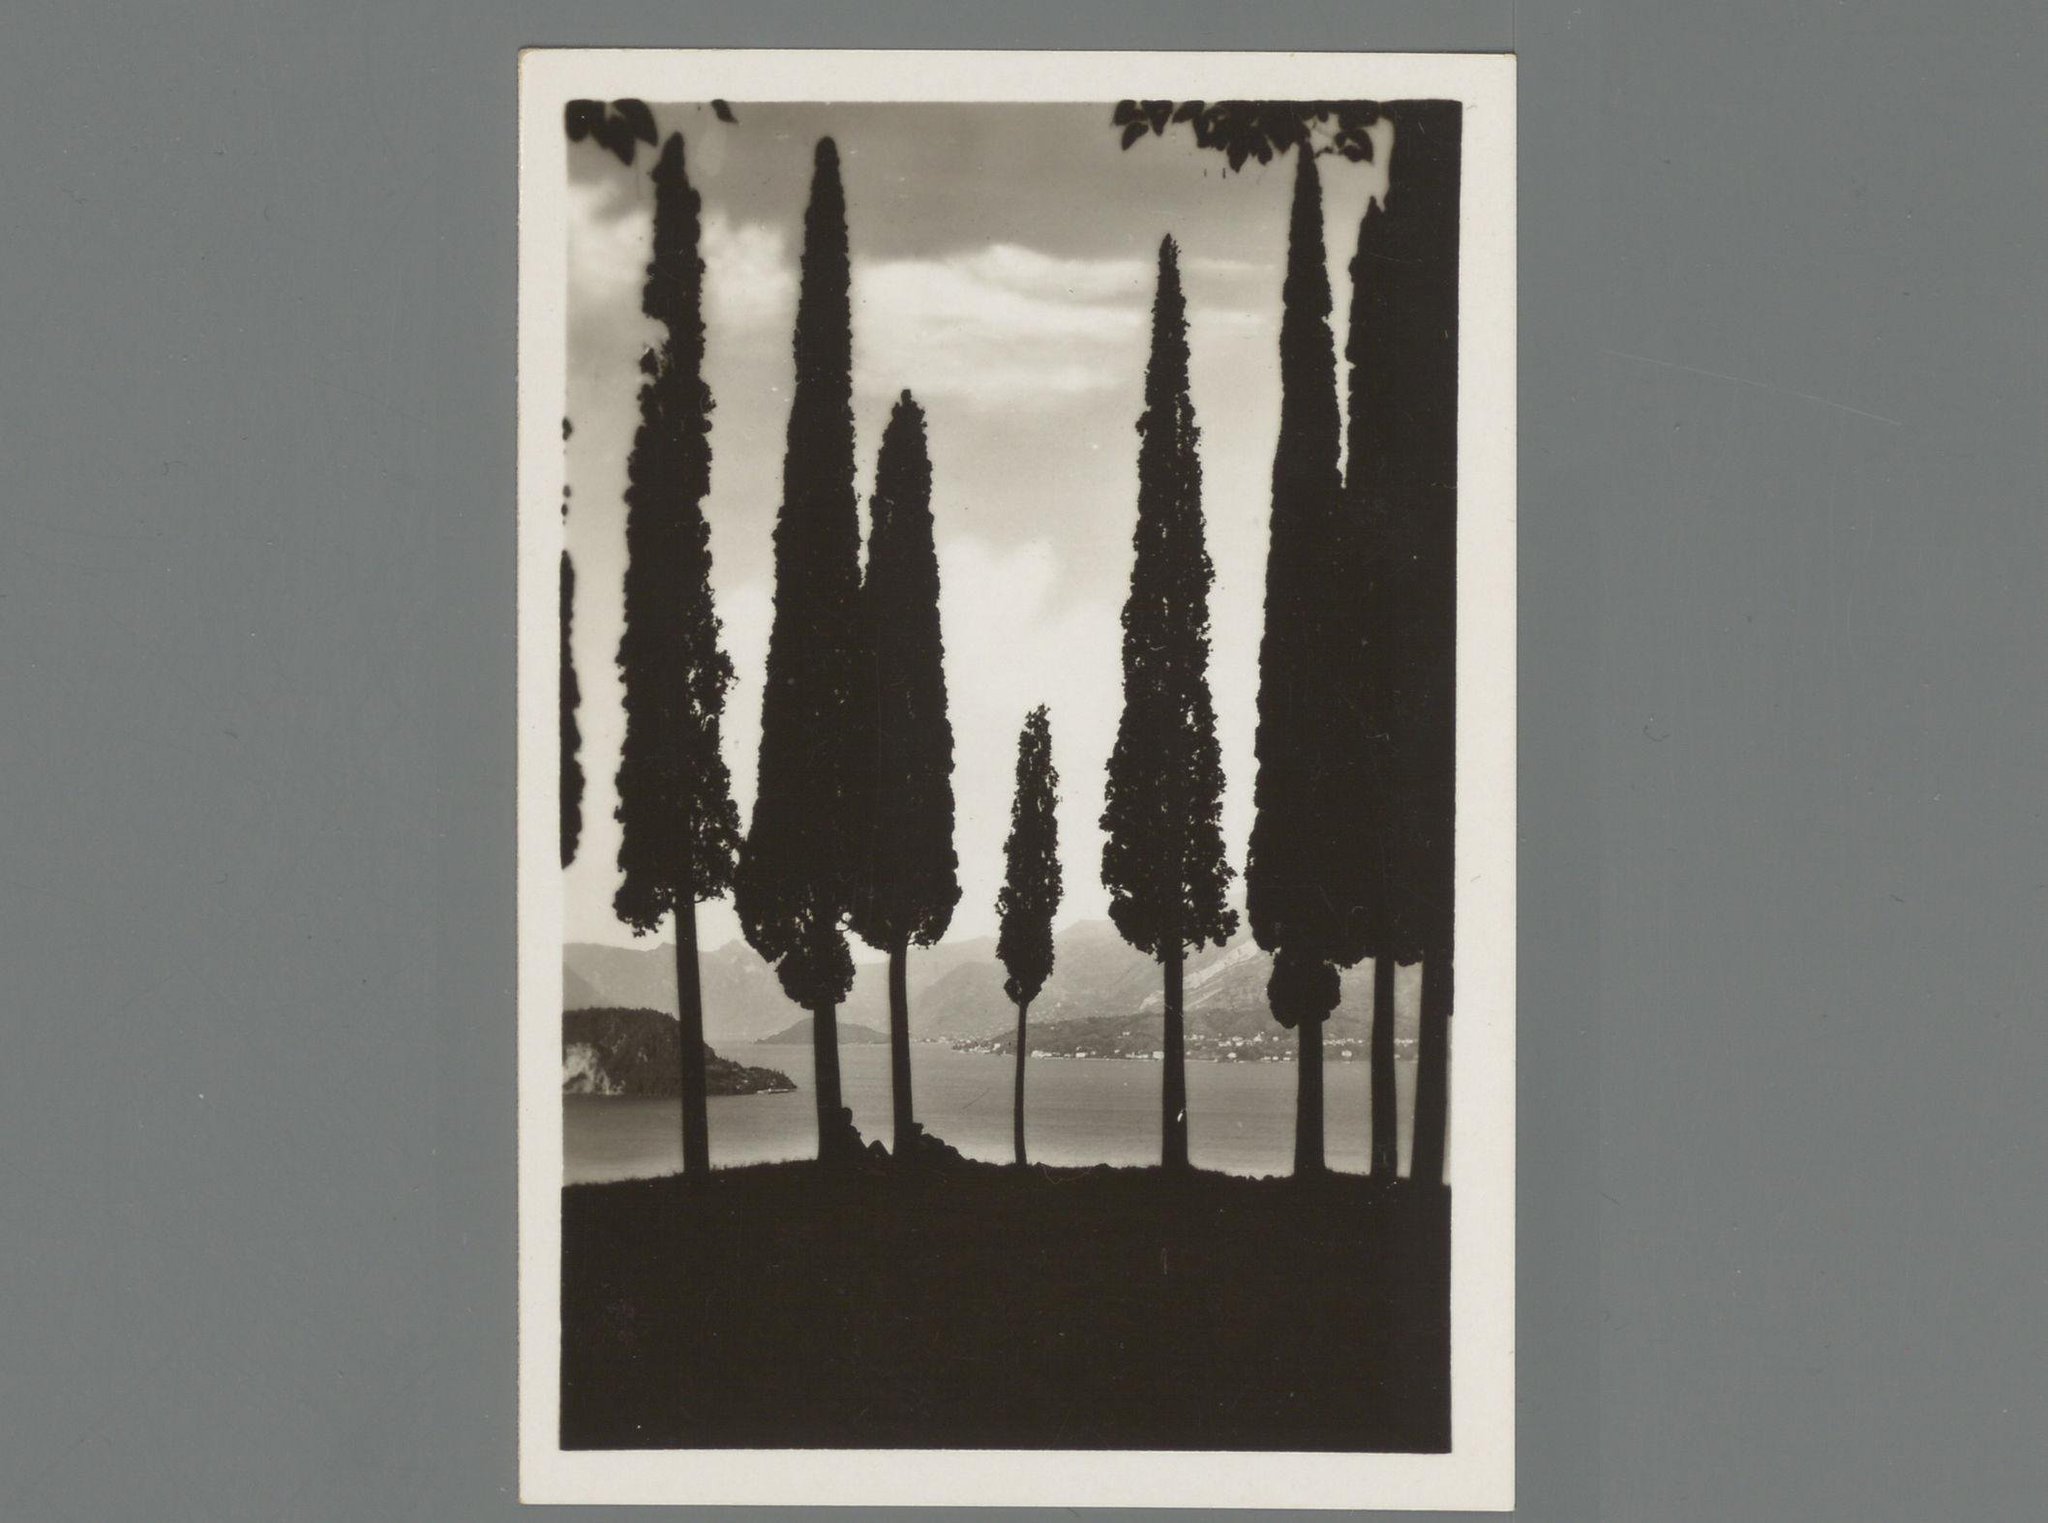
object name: photograph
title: Cipressi a Varenna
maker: Anonymous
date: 1910-1930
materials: paper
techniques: gelatin silver print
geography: varenna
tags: trees: cypress, lake